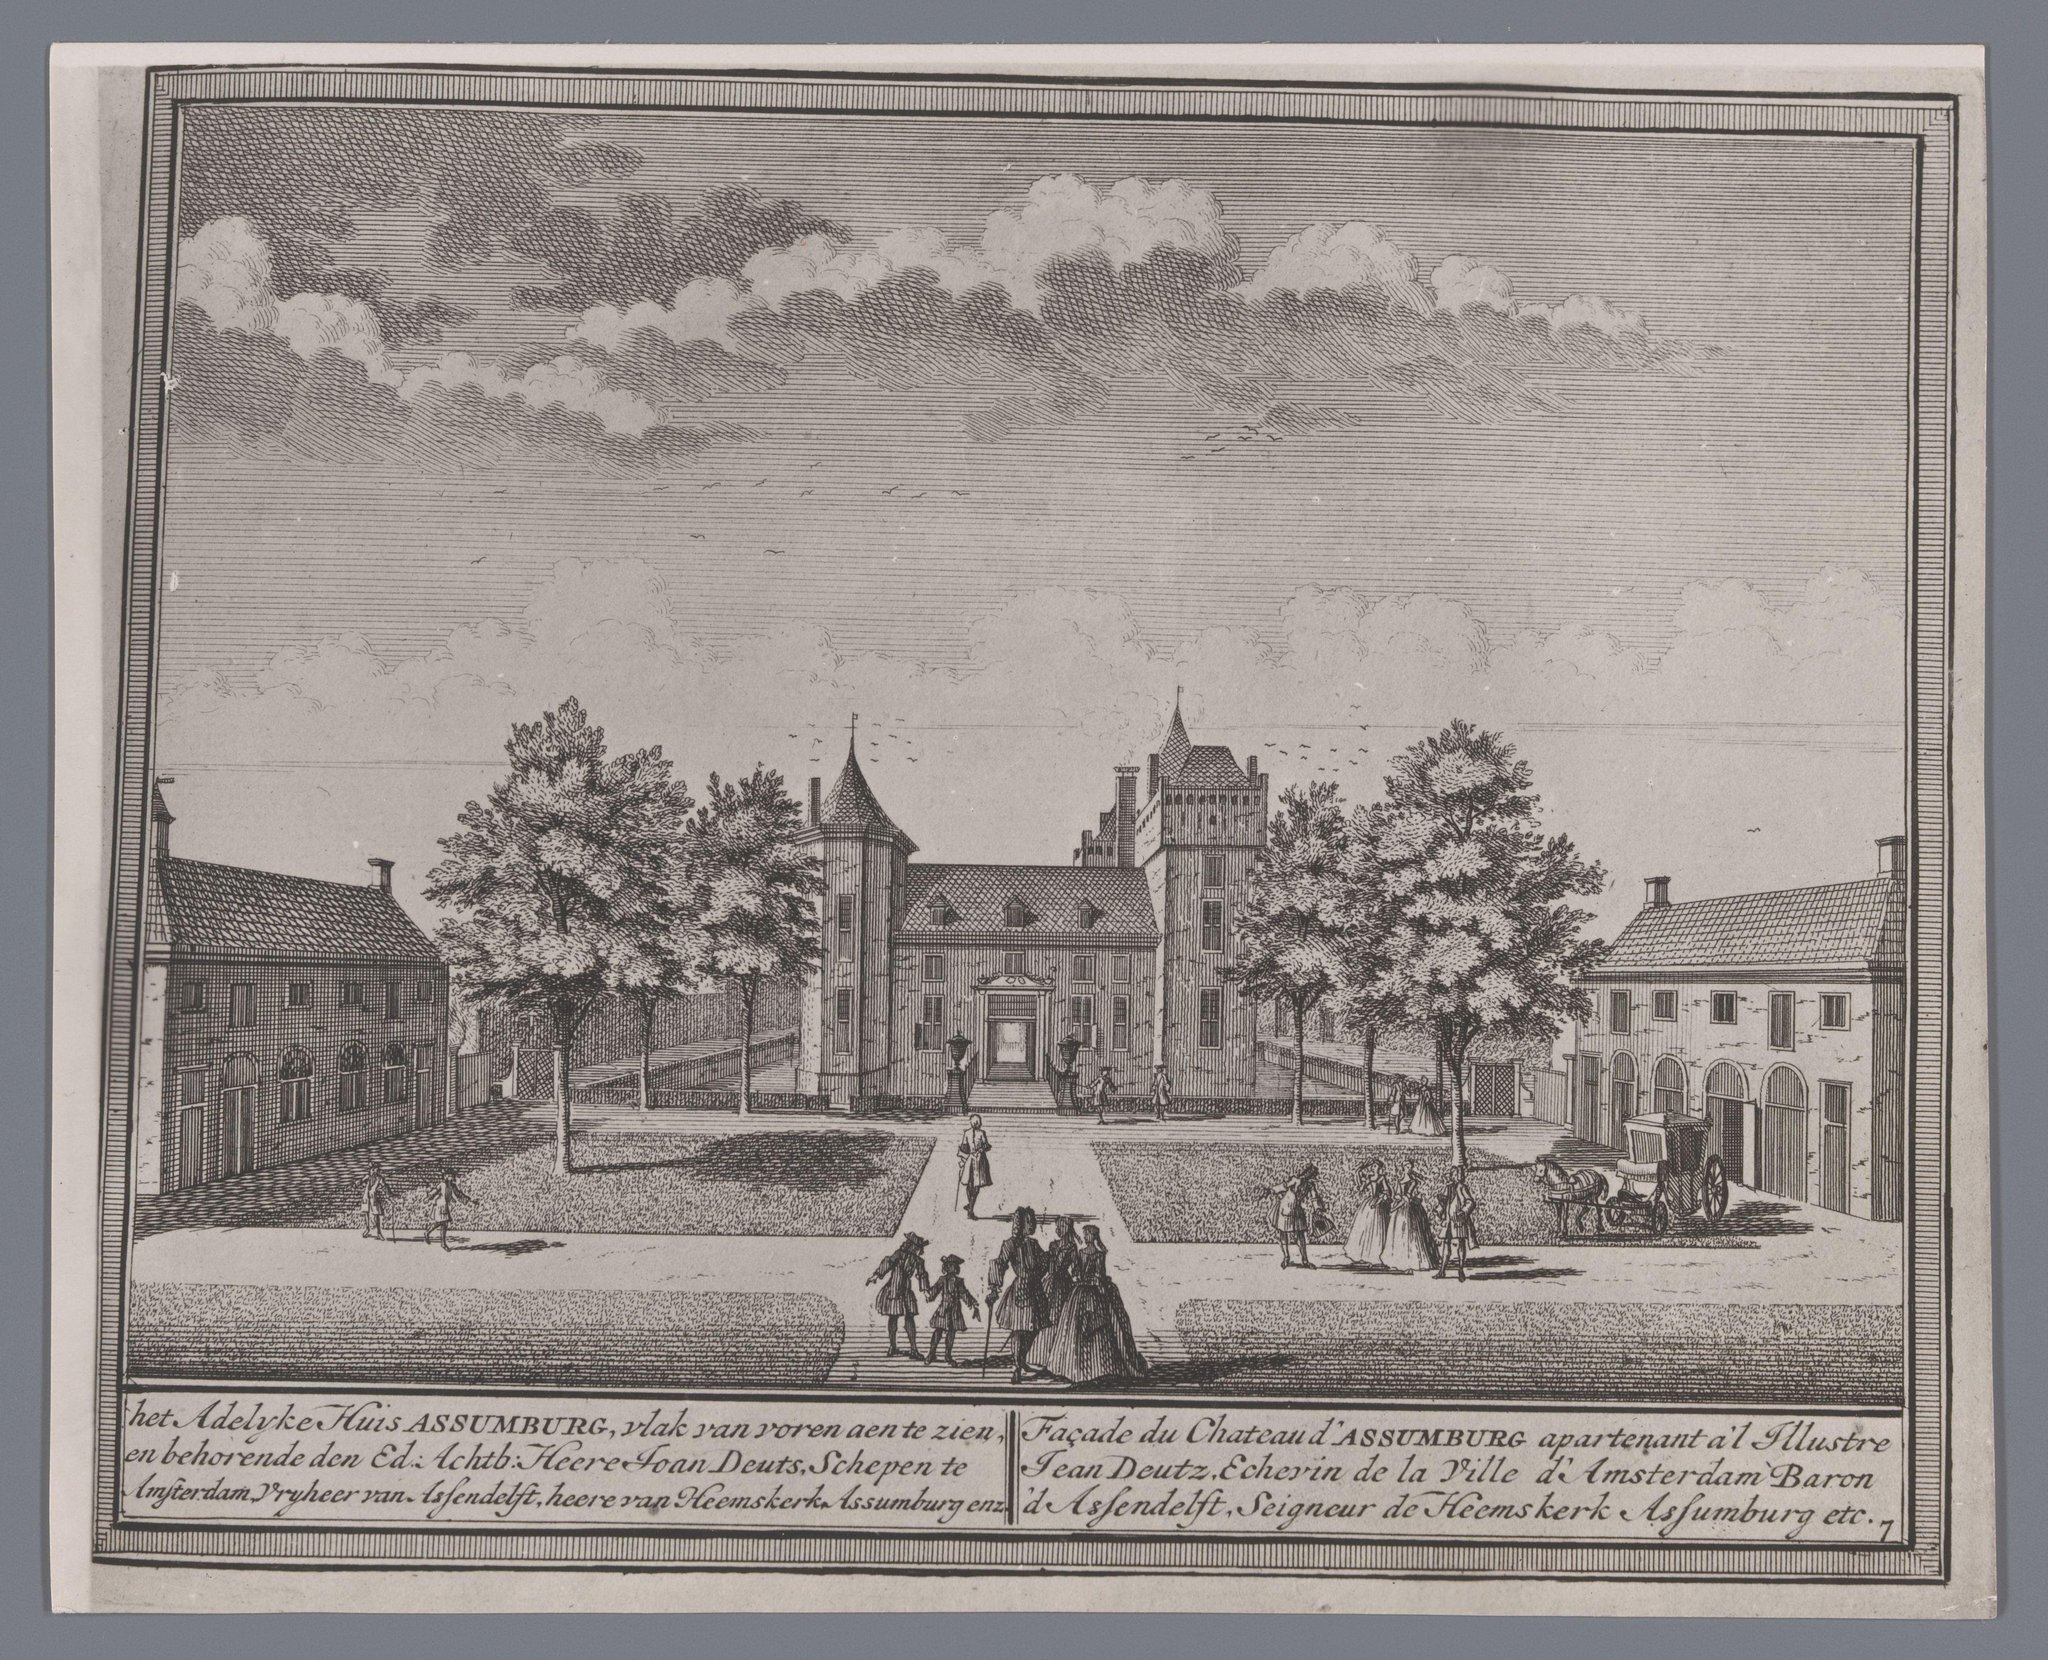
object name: reproduction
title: Fotoreproductie van een prent van een gezicht op het huis Assumburg te Heemskerk door Hendrik de Leth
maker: Anonymous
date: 1900-1930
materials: photographic support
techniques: gelatin silver print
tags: villa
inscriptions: inscription: ‘het Adelyke Huis Assumburg, vlak van voren aen te zien, en behorende den Ed. Achtb. Heere Joan Deuts, Schepen te Amsterdam vryheer van Assendelft, heere van Heemskerk Assumburg enz.’, annotation: ‘Heemskerk’, collector's mark: Lugt 2233, number: ‘'22.57.’